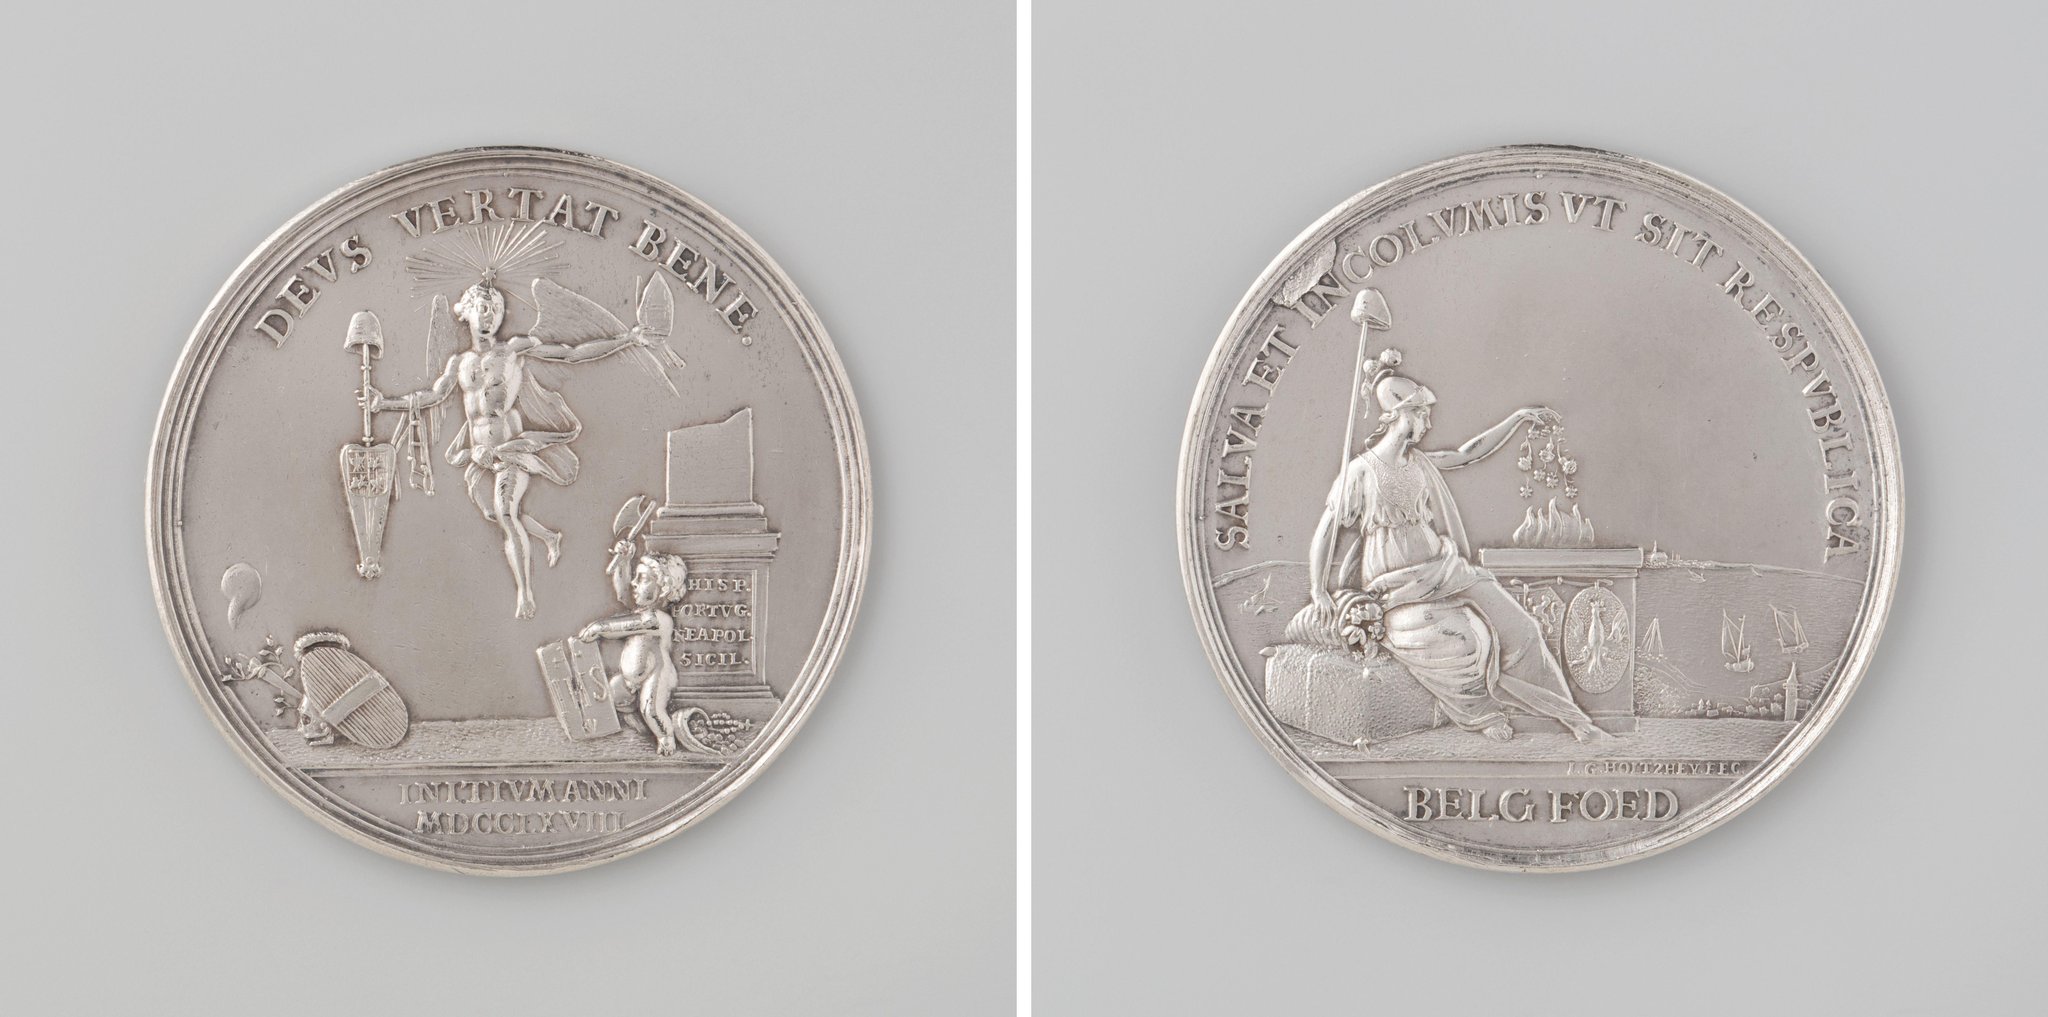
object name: new year medal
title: Aanvang van het jaar 1768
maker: johan george holtzhey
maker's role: mintmaster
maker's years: 1726-1808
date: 1768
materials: silver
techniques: striking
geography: amsterdam